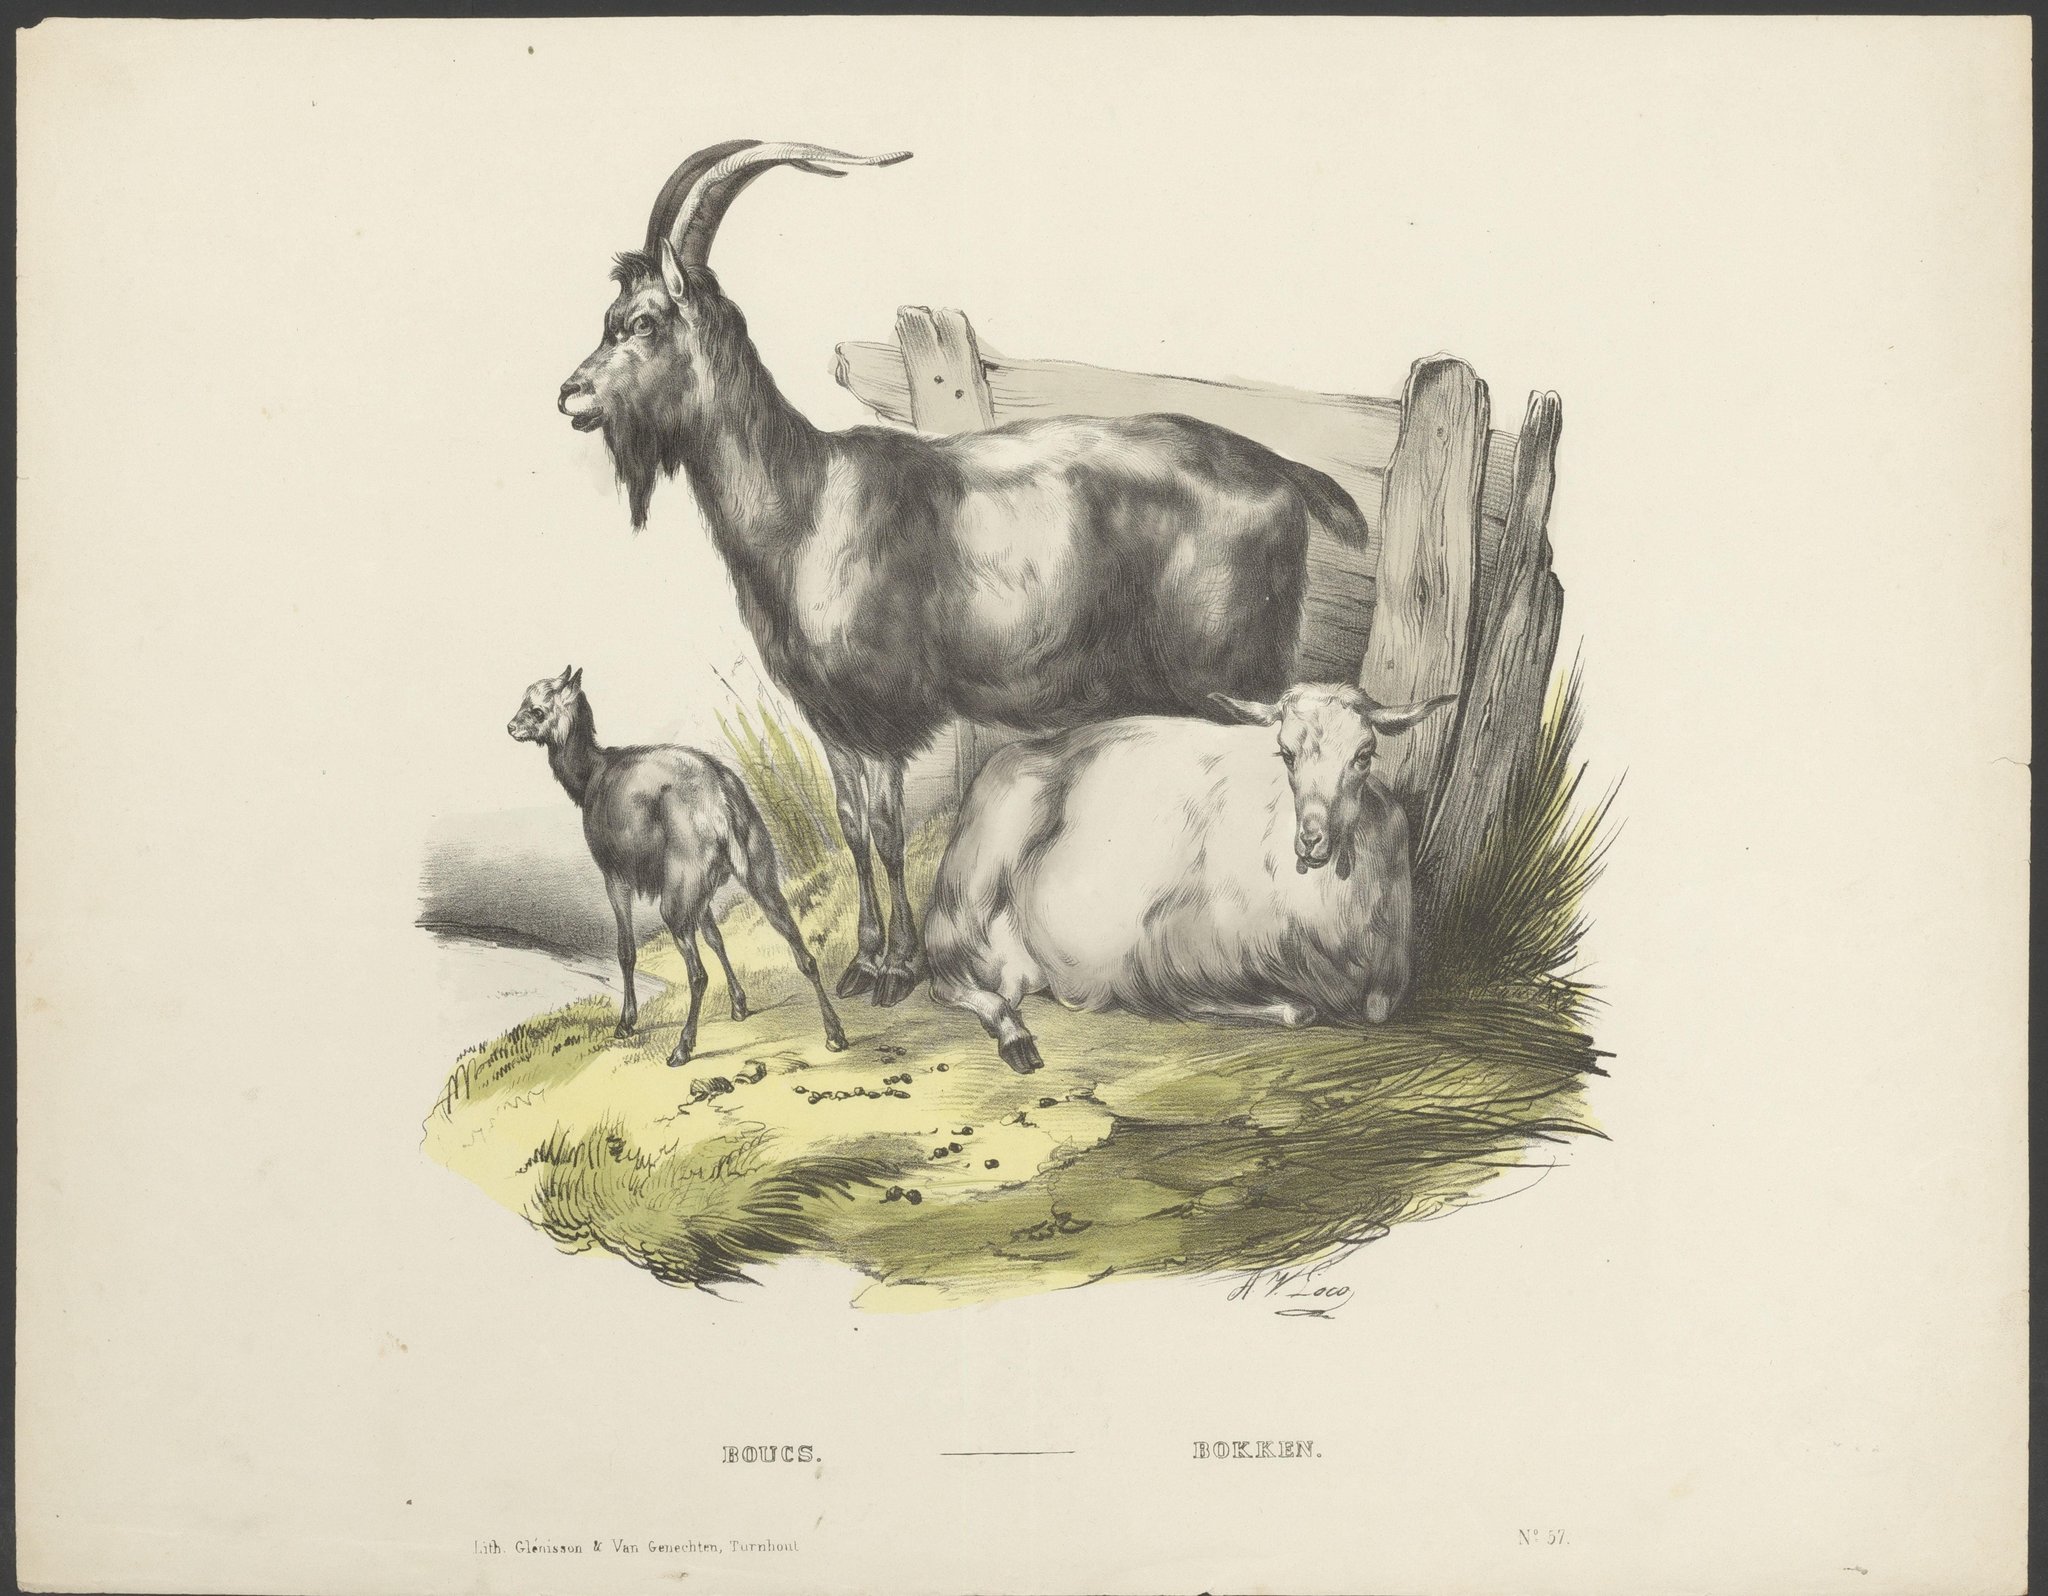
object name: popular print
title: Boucs - Bokken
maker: a. van loco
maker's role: print maker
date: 1833-1856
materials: paper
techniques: hand coloring, letterpress printing, lithograph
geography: turnhout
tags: he-goat, billy-goat, kid (goat), she-goat, nanny-goat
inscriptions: stamp, collector's mark: Lugt 1641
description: Blad met een grote voorstelling van een bok, een geit en een jong bokje voor een hek. Onder de voorstelling de titel. Genummerd rechtsonder: No. 57. Onderwerpsrubrieken binnen de Atlas Zeden en Gewoonten: Zeden en Gewoonten in Engeren Zin, Des menschen beging, midden en einde, Kinderleven – Kinderspel en Kinderprenten.